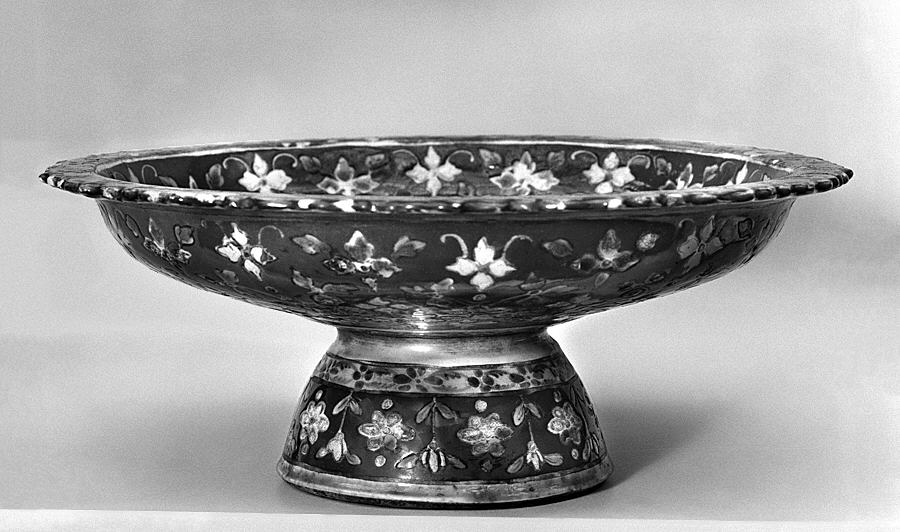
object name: dish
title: Footed dish with Thai mythical figures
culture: chinese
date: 1801-1900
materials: enamel, porcelain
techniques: overglaze, painting, polychrome